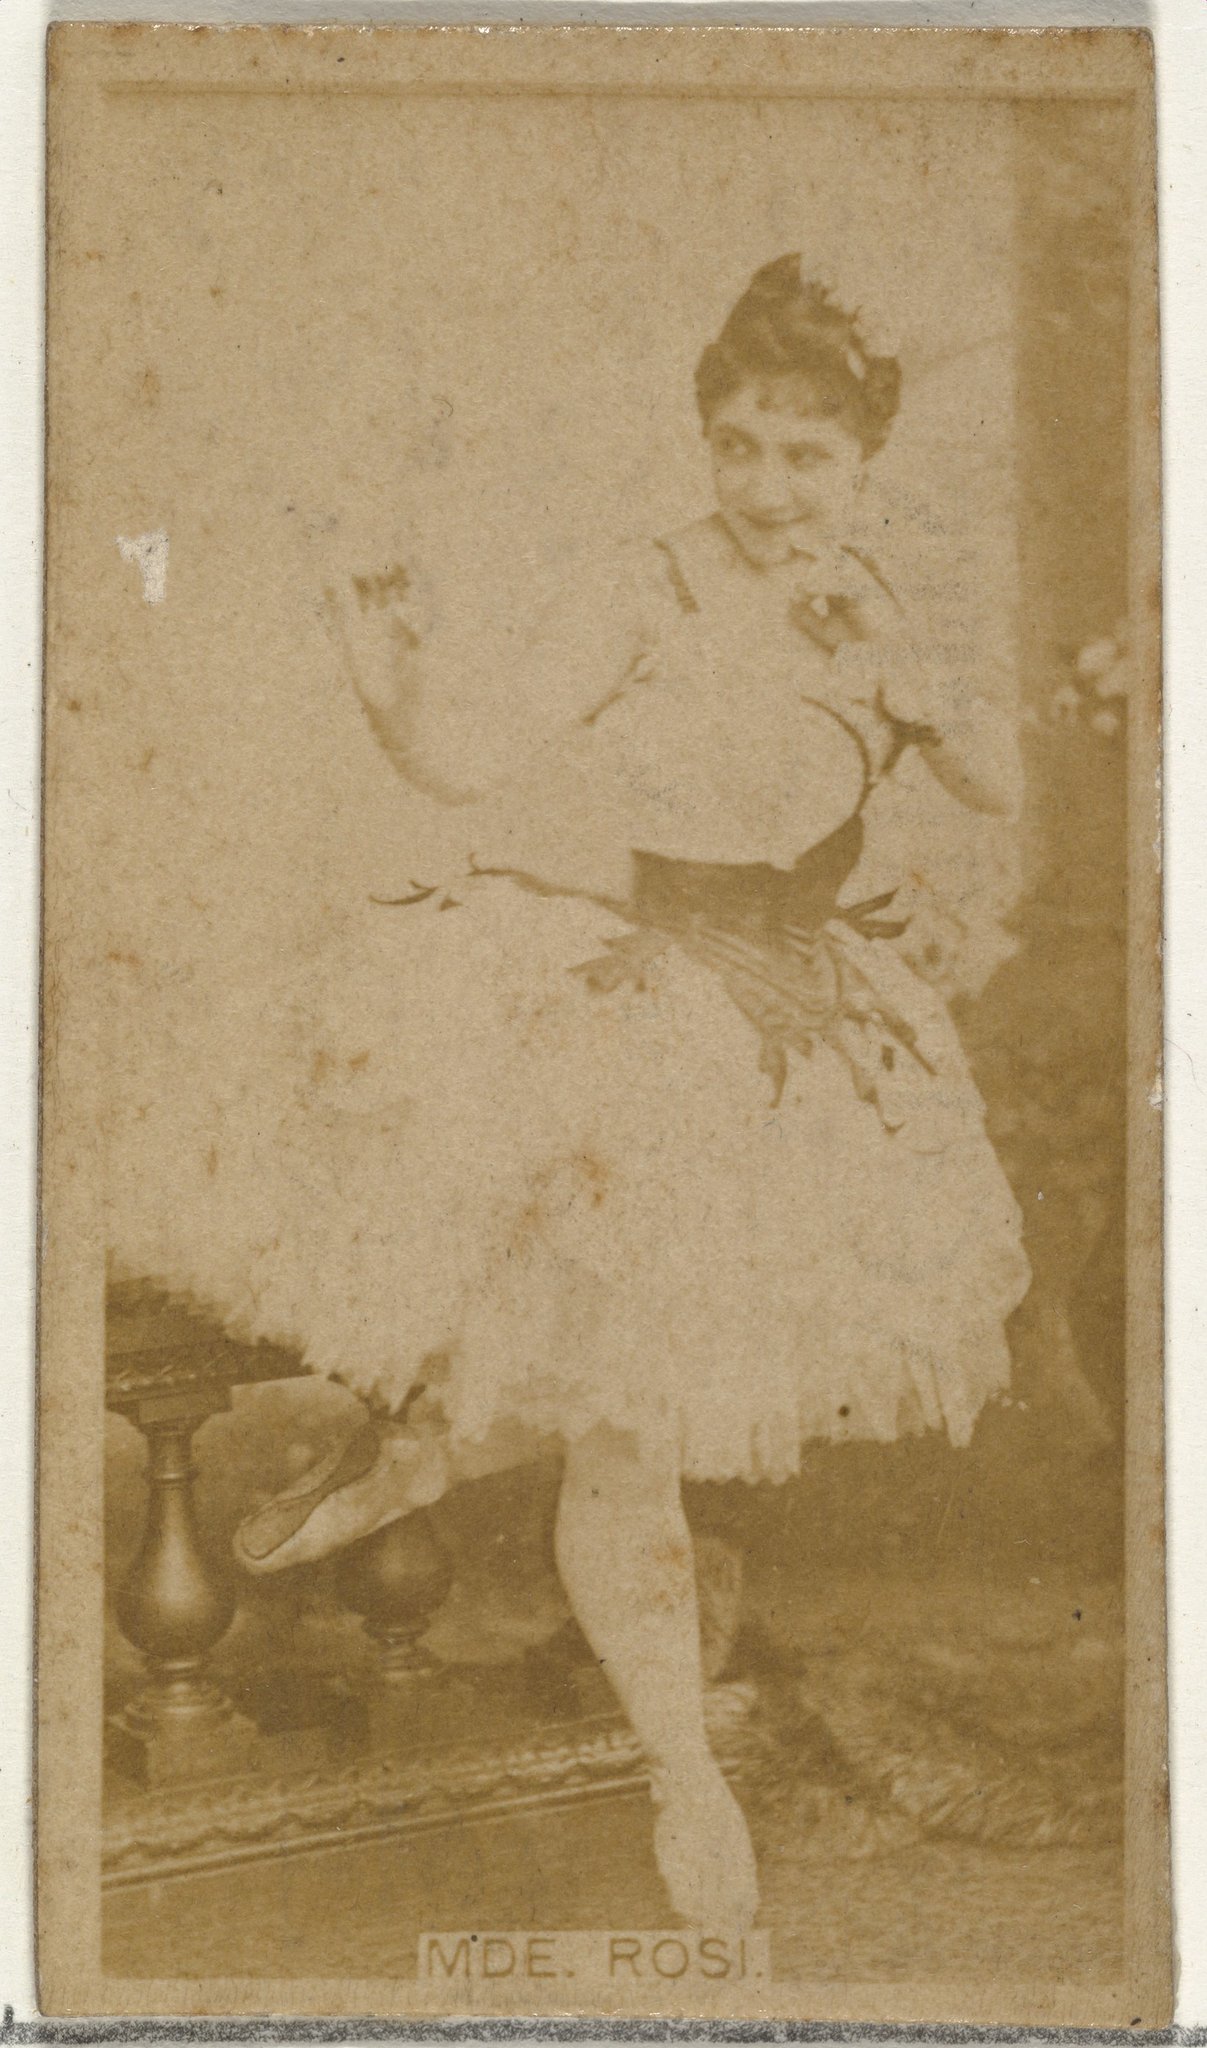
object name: photograph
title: Mde. Rosi, from the Actors and Actresses series (N145-8) issued by Duke Sons & Co. to promote Duke Cigarettes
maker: w. duke, sons & co.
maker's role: publisher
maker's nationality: american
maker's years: 1870-1920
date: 1891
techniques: albumen silver print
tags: portraits,women,actresses